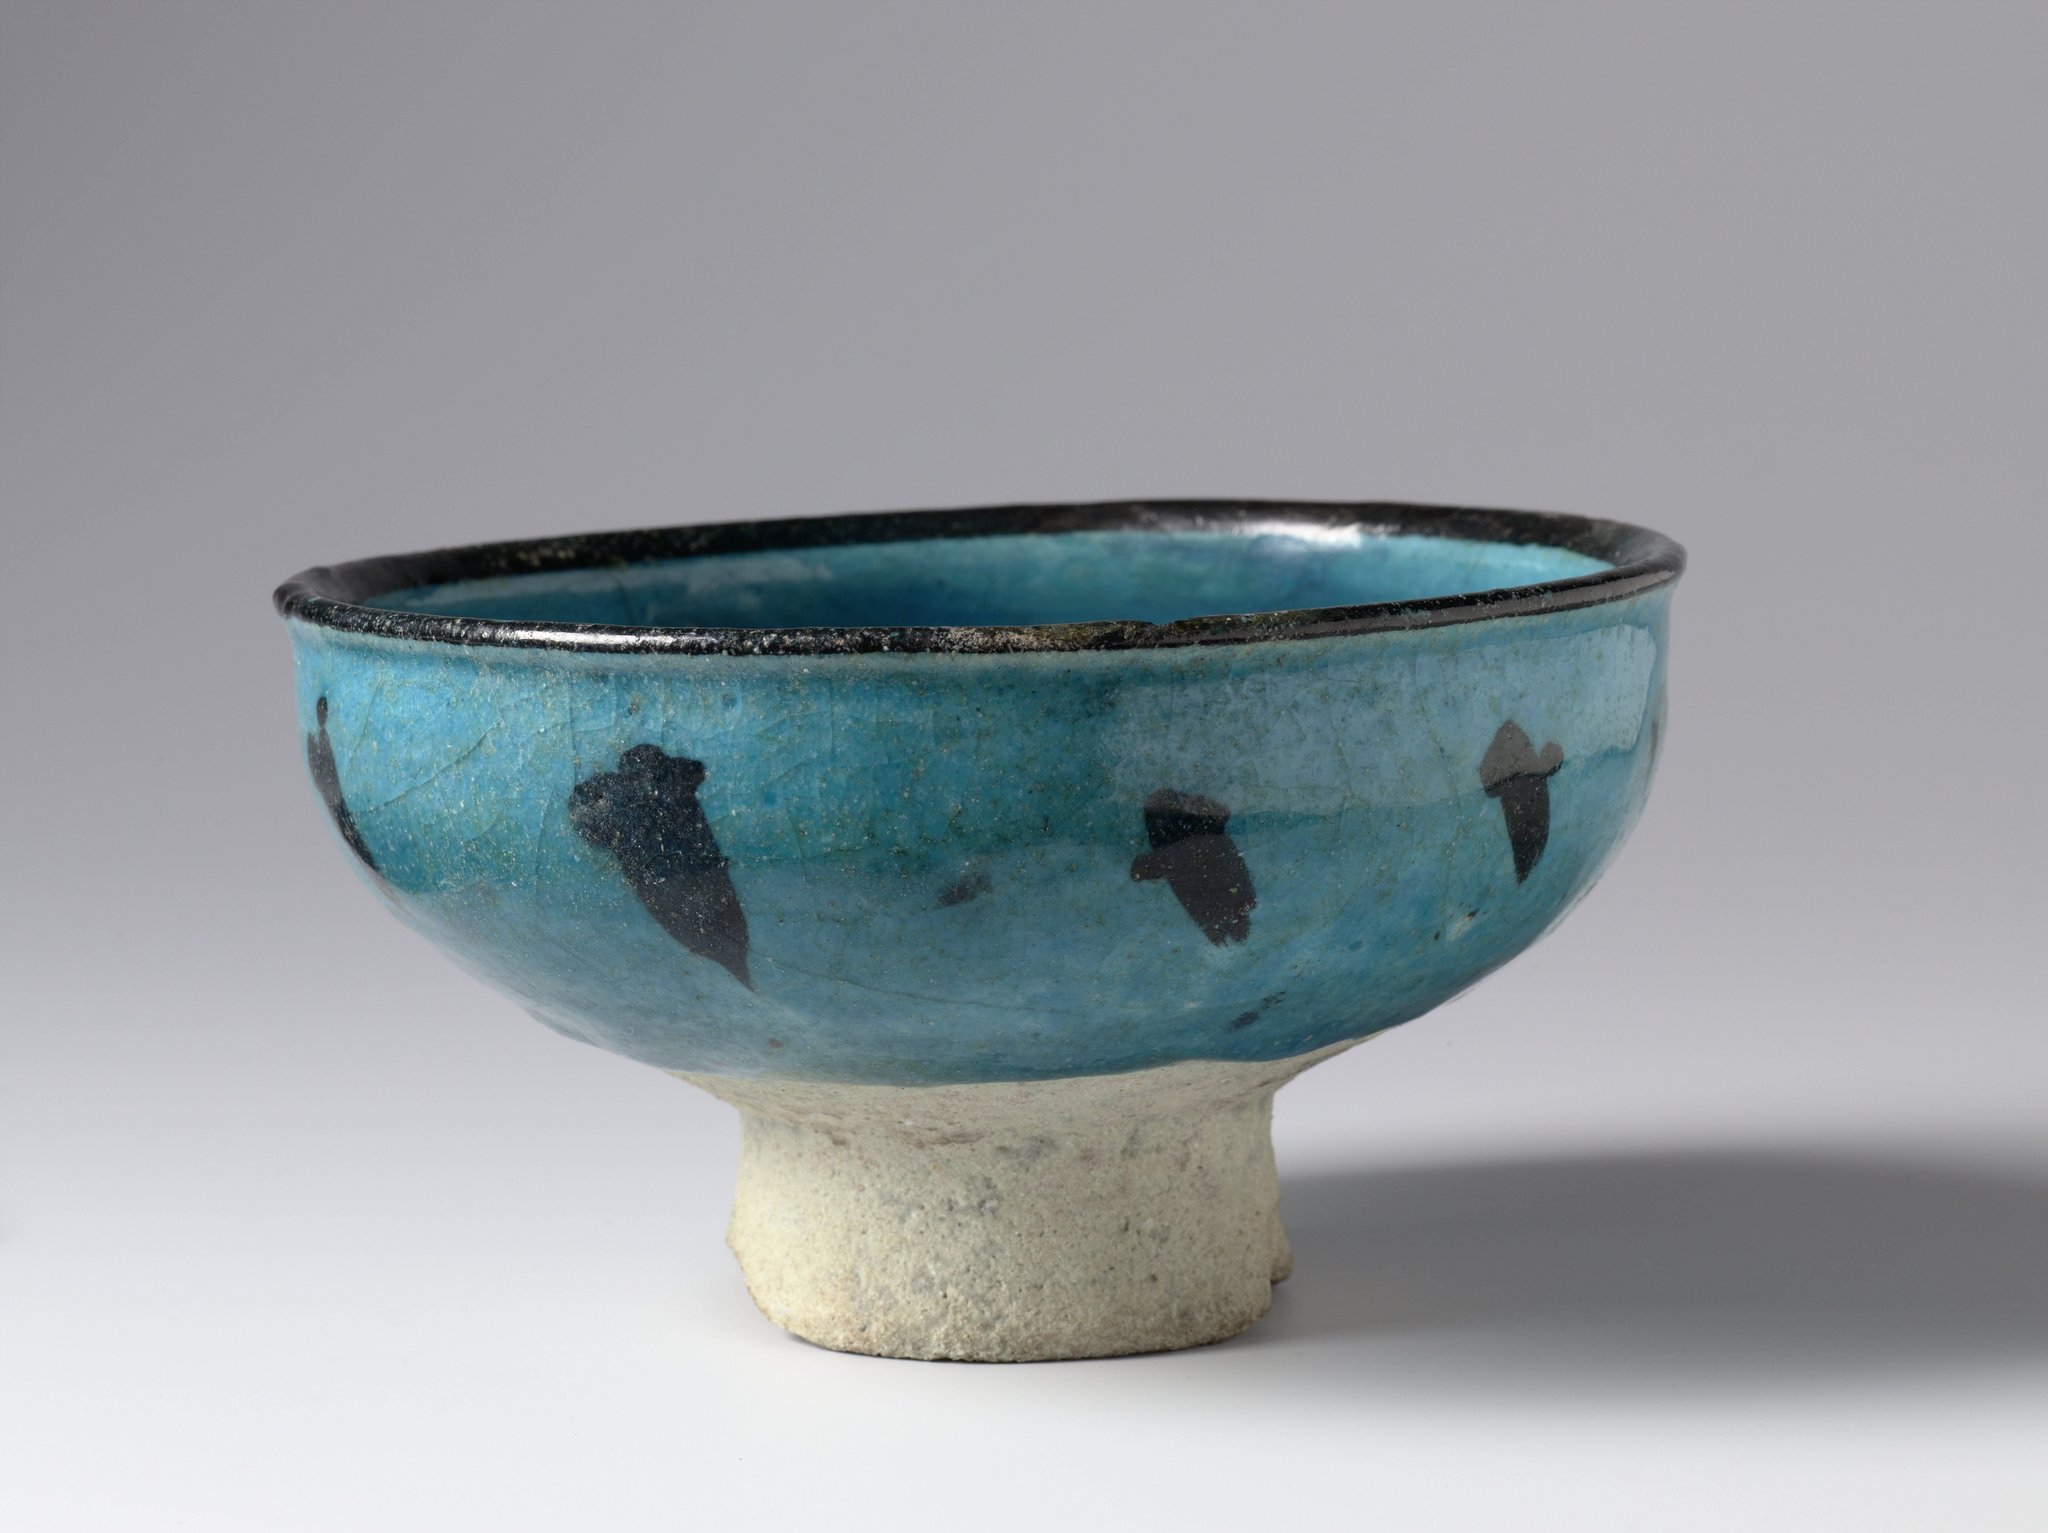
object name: bowl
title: Bowl with a stylized flowering plant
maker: Anonymous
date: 1200-1299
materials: earthenware, glaze, paint, quartz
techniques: firing, turning, vitrification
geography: raqqa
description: Kom van kwarts-fritgoed gedecoreerd met op de bodem een gestileerde bloeiende plant in zwart onder een monochrome transparante turquoise glazuur.